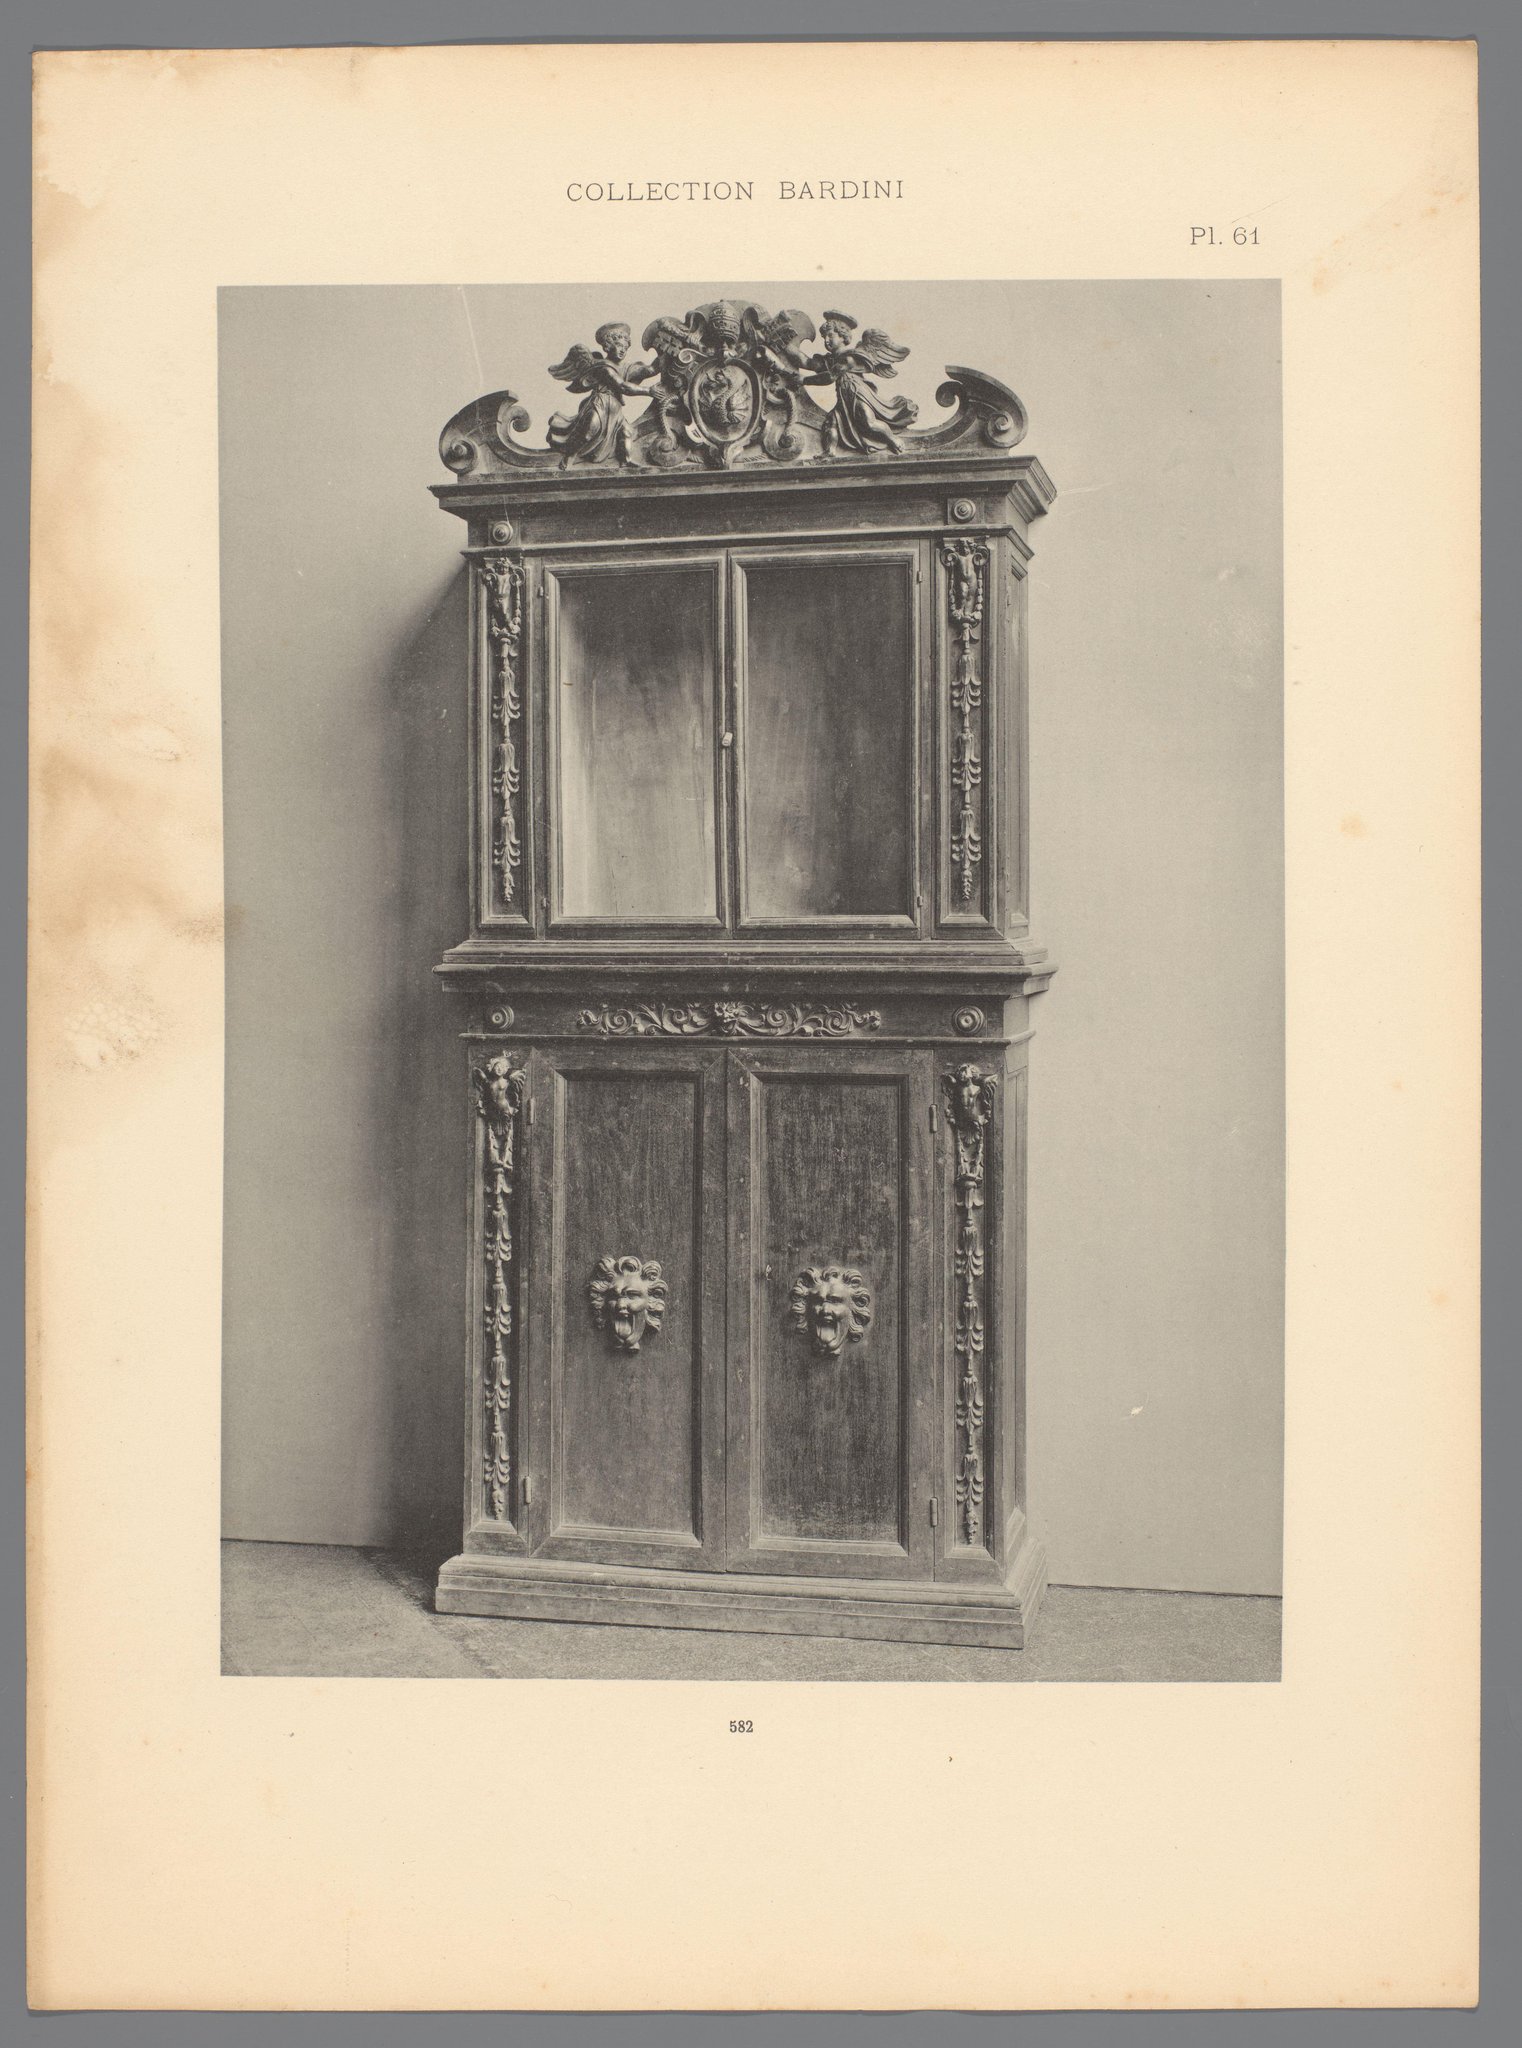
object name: photomechanical print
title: Gedecoreerd kabinet met twee glazen deuren in het bovenste deel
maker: Anonymous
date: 1875-1930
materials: paper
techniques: photograph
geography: florence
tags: ornamental cupboard (+ wood and other phytogenic material)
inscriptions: number: ‘Pl. 61’